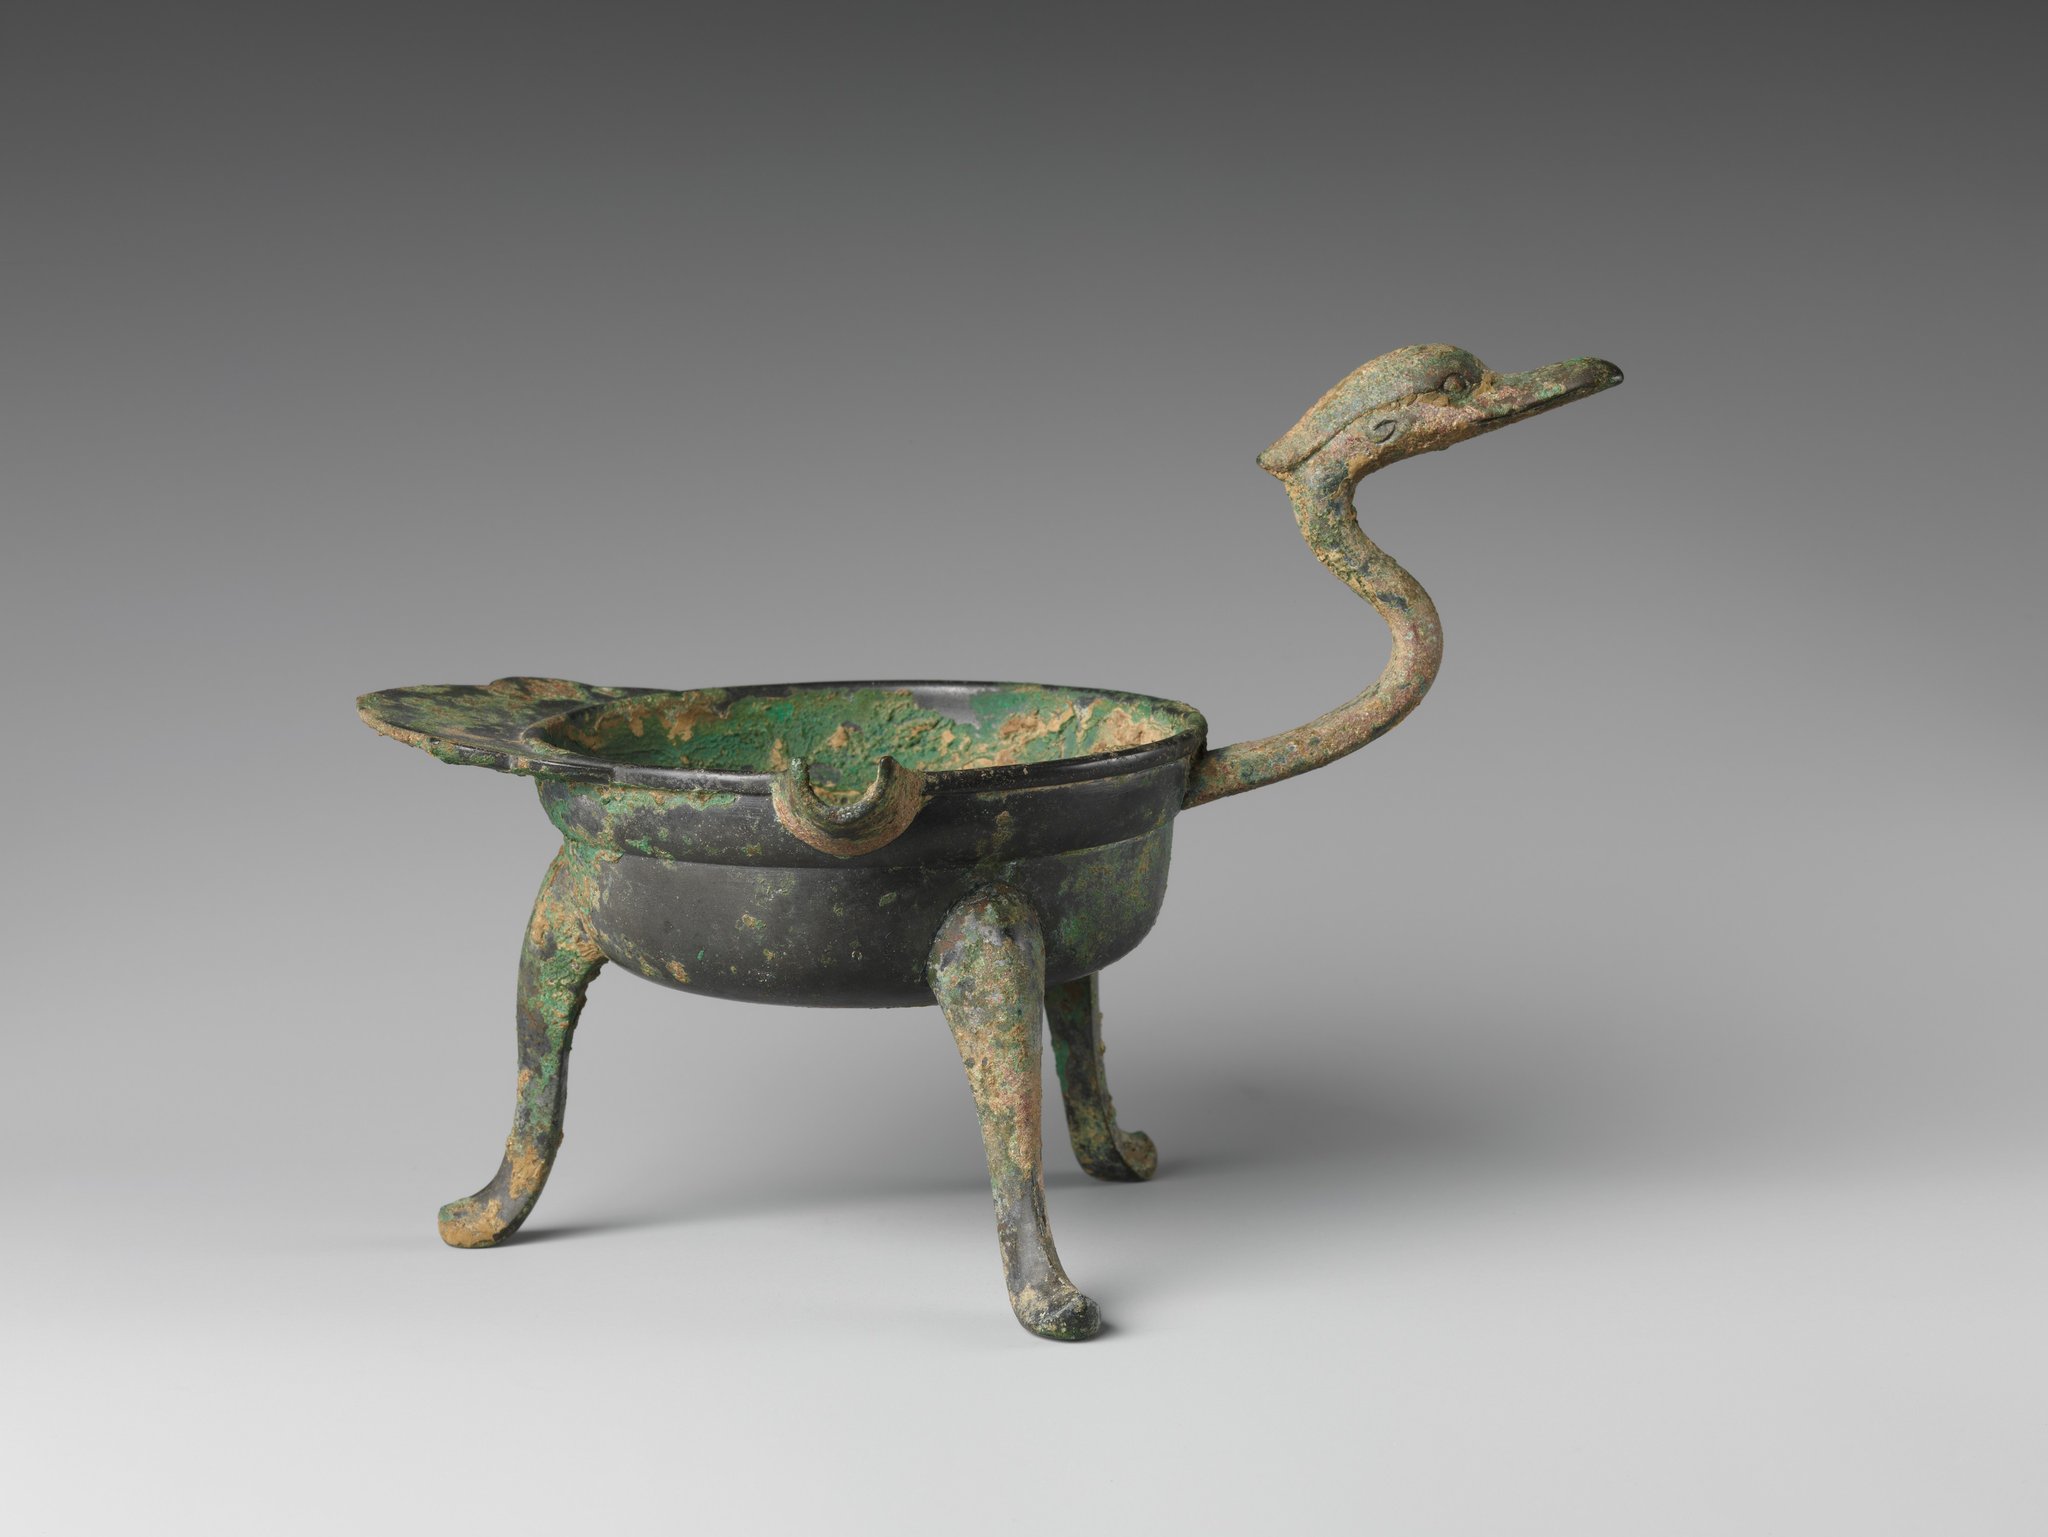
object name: heating vessel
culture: chinese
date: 801-900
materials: bronze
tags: birds